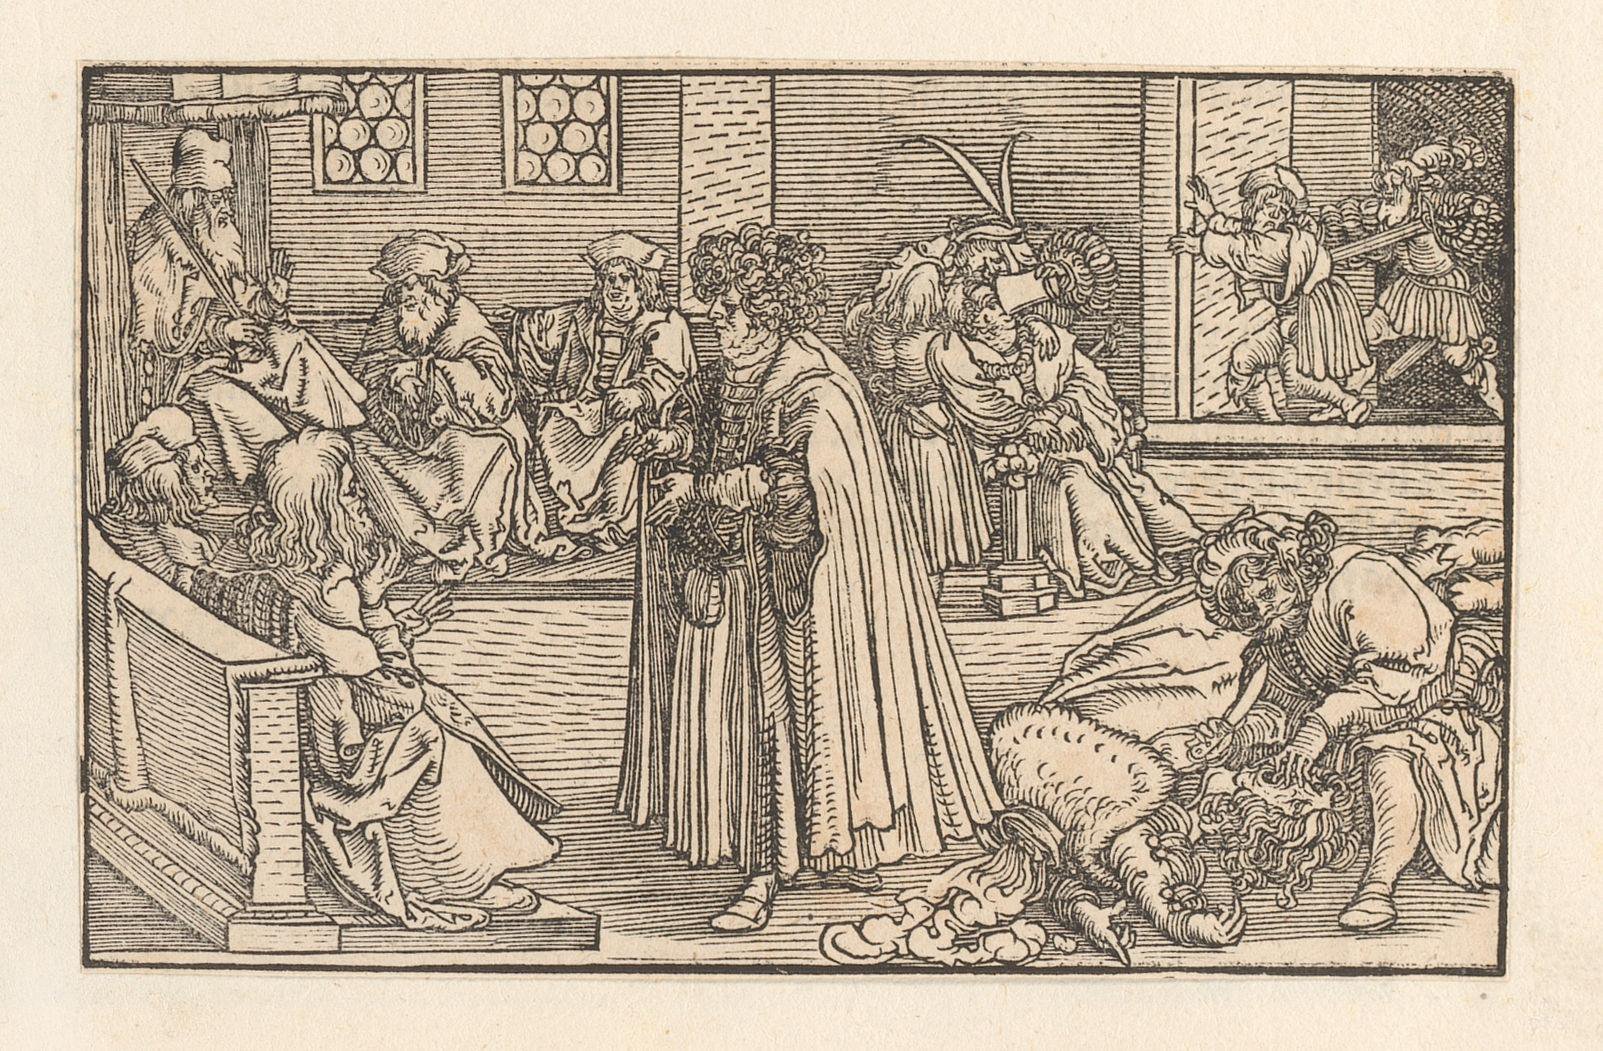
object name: album leaf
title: Man in een rechtbank terwijl drie moorden worden gepleegd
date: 1514-1532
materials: paper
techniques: letterpress printing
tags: violent death by cleaving and striking weapons, violent death by poisoned cup, administration of justice, trial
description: Deze prent is gebruikt in: Petrarca, Francesco. Von der Artzney bayder Glück, des guten und widerwertigen: unnd weß sich ain yeder inn Gelück und Unglück halten sol (...). Augsburg: Heinrich Steiner, 1532. Deze uitgave is ook bekend onder de titel 'Trostspiegel in Glück und Unglück'. Deze prent is ook gebruikt in: Cicero, Marcus Tulius. Officia M.T.C. Ein Buch so Marcus Tullius Cicero der Römer zu seynem (...). [Vertaald uit het Latijn door] Johann von Schwarzenberg. Augsburg: Heinrich Steiner, 1531.